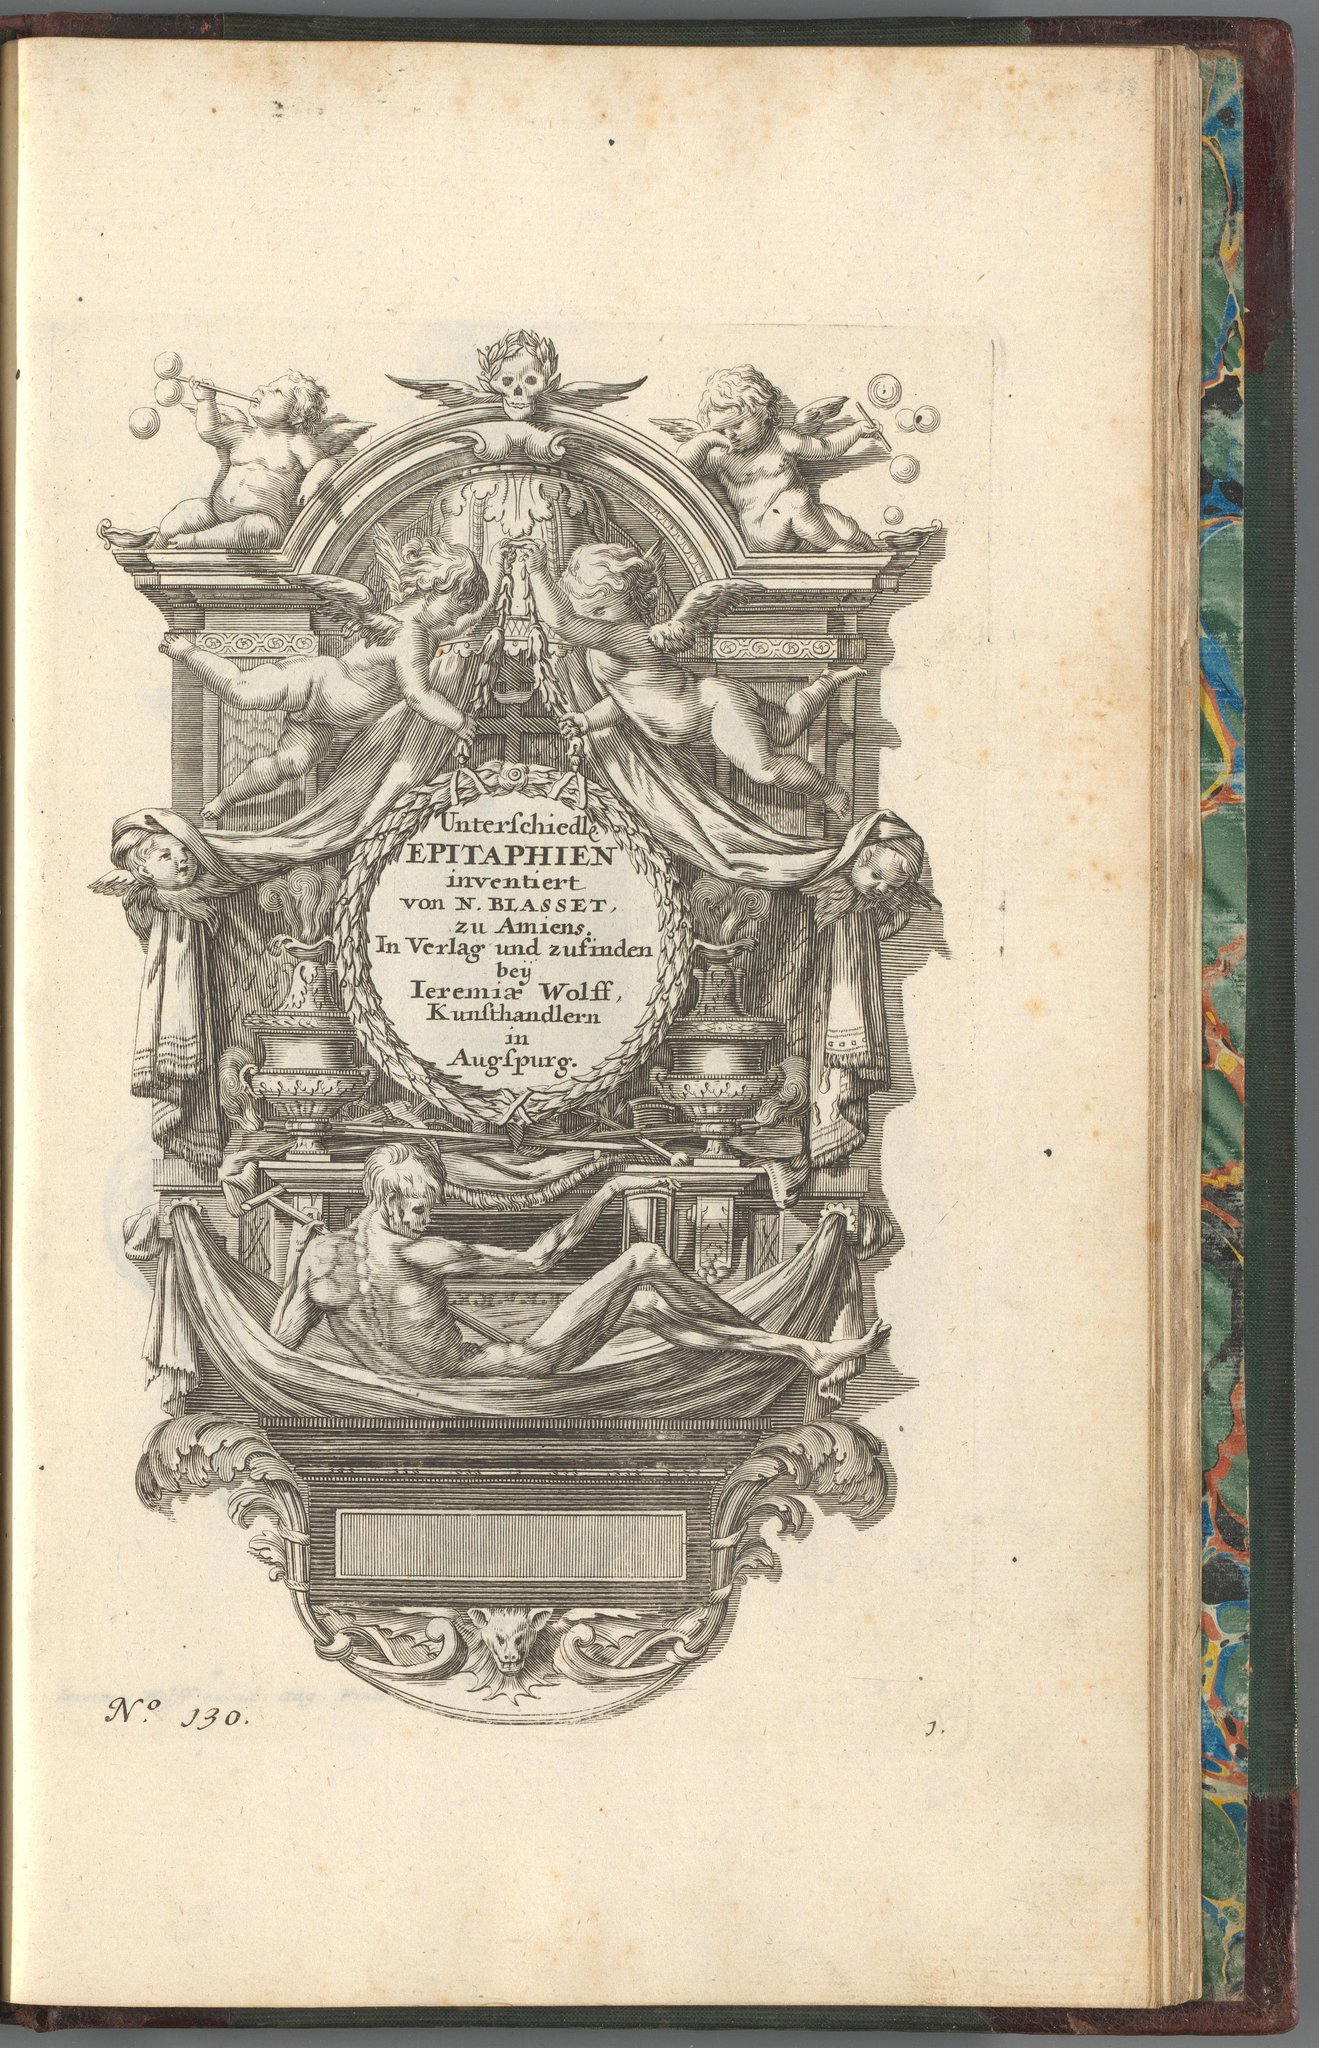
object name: titelprent, frontispice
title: Titelprent van een serie grafschriften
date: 1686-1724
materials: paper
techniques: engraving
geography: augsburg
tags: ornaments ~ art, title-page, epitaph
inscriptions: signature: ‘In Verlag und zufinden beij Ieremiae Wolff’, number: ‘No. 130.’, signature: ‘inventiert von N. Blasset’, number: ‘1.’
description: Een titelprent van een serie van zeven grafschriften. Prent maakt deel uit van een album. Gespiegelde kopie naar Frans origineel.